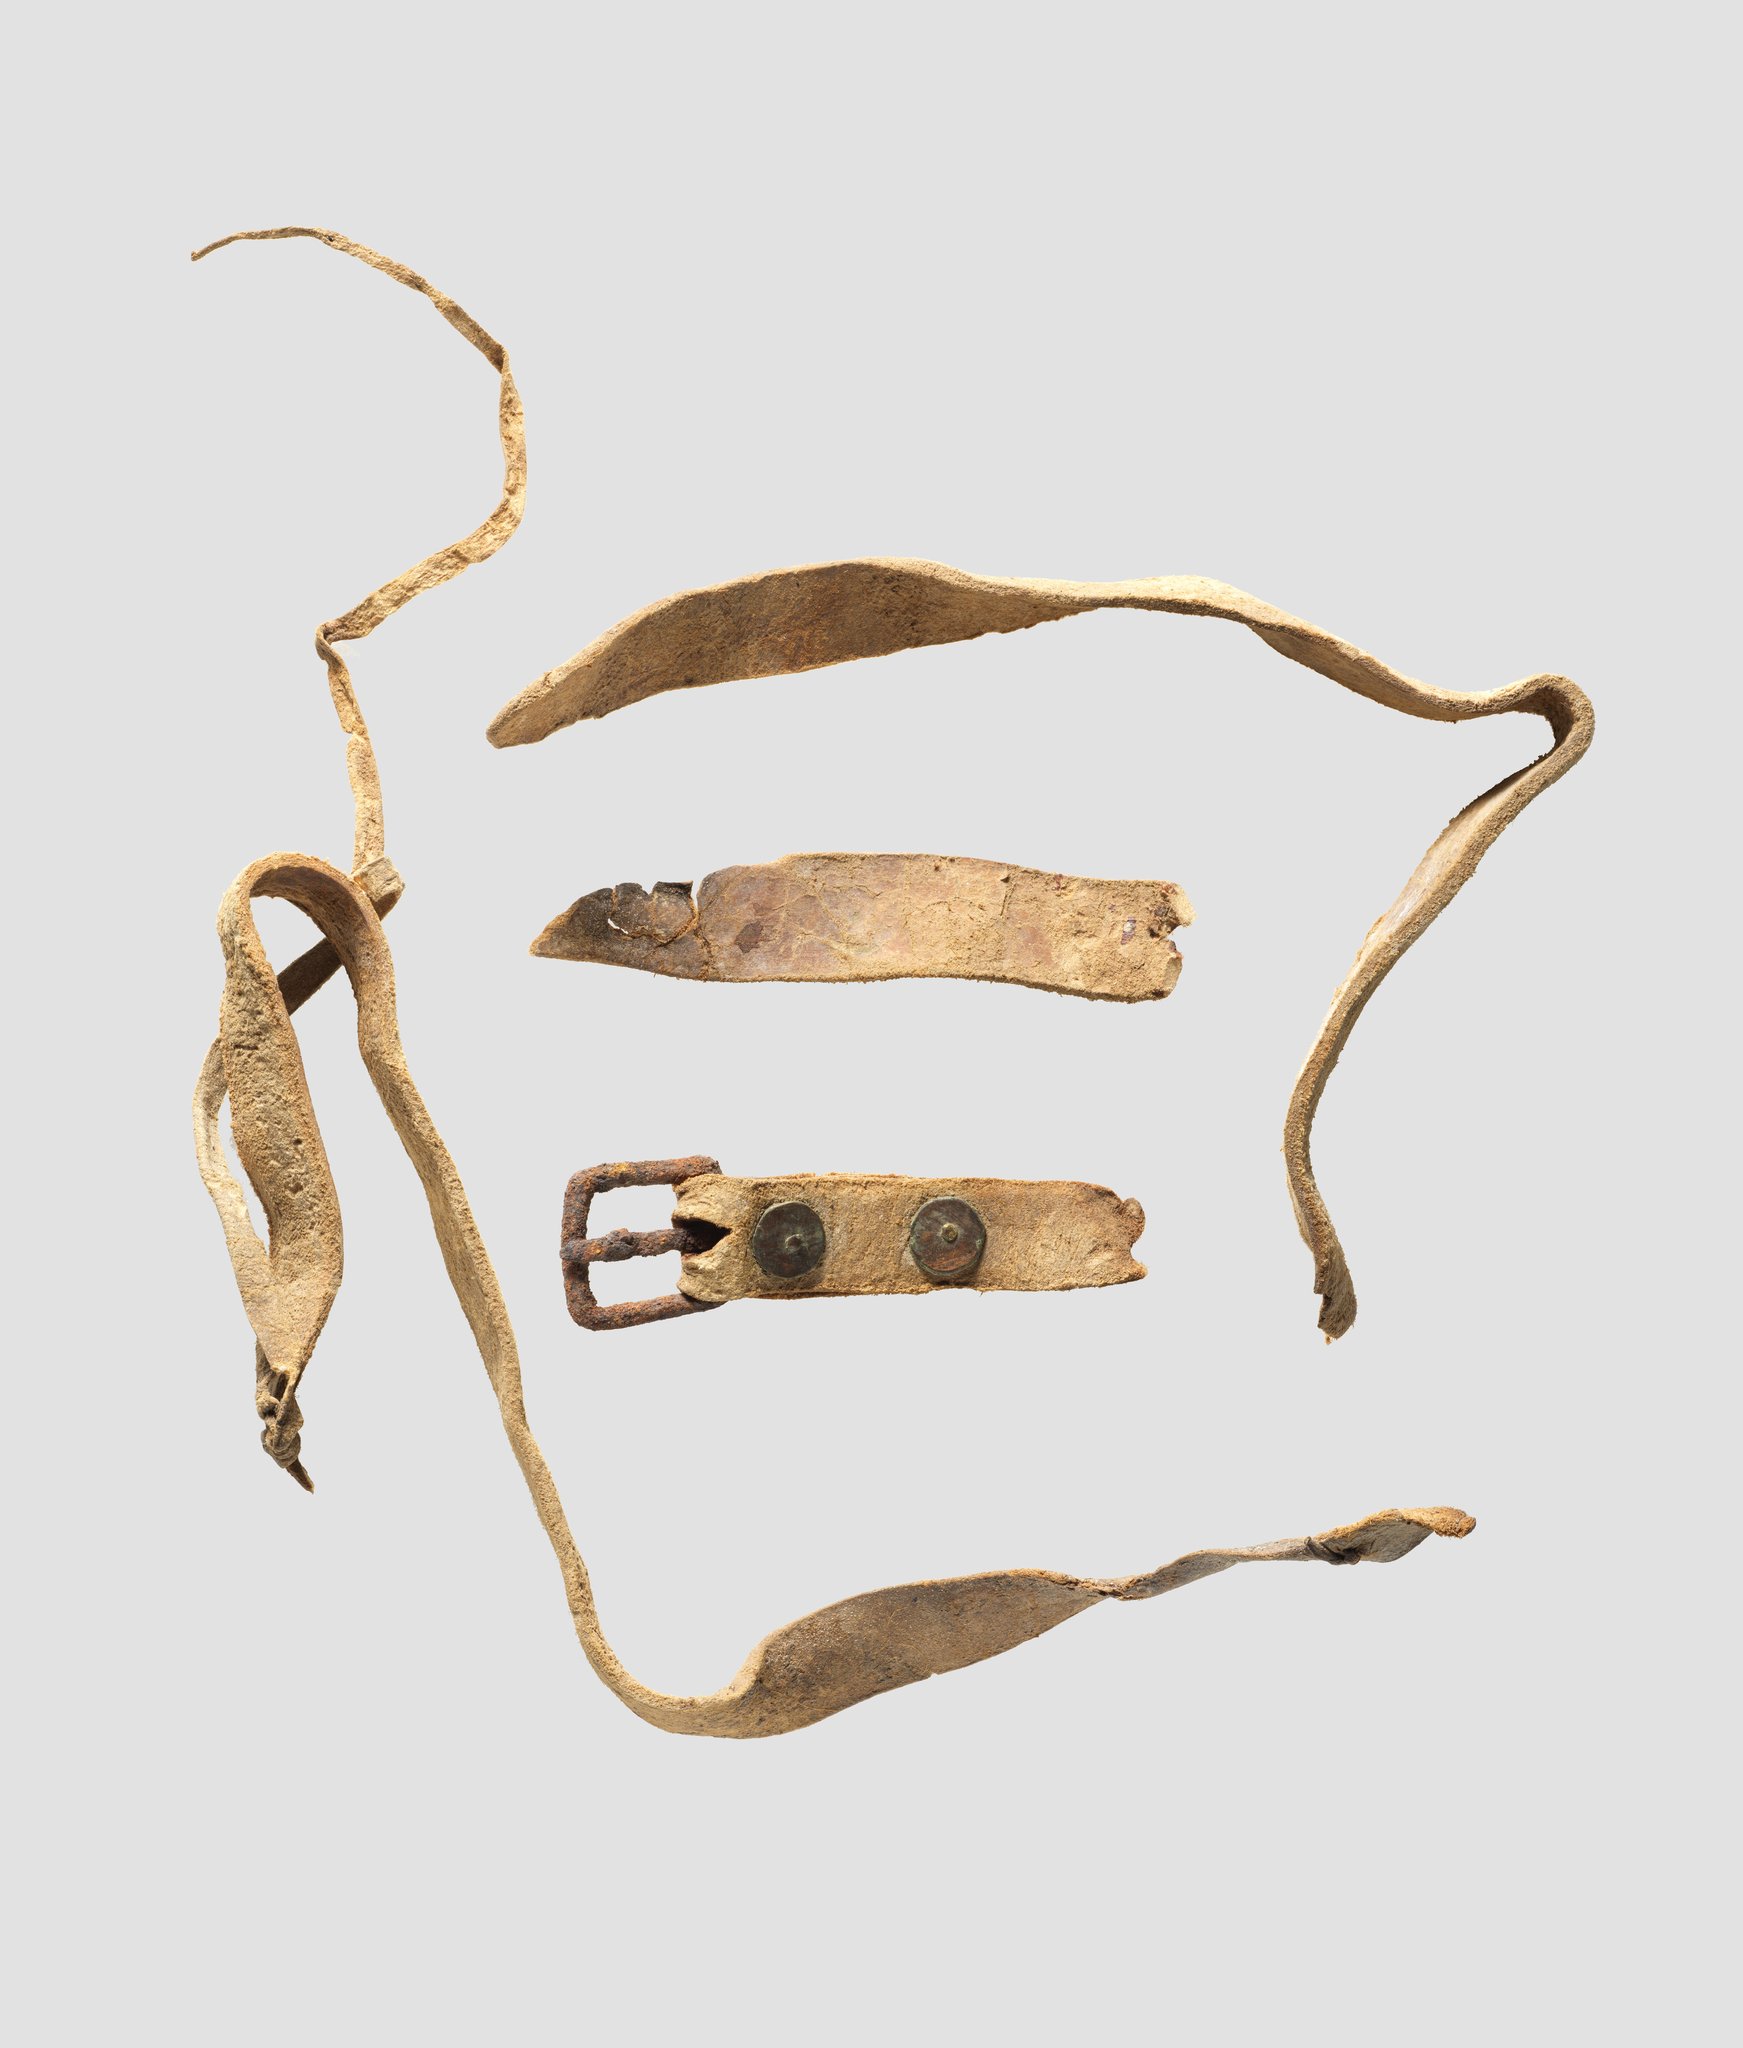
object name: strap with buckle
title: Leather belt strap with buckle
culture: alanic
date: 601-900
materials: leather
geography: caucasus